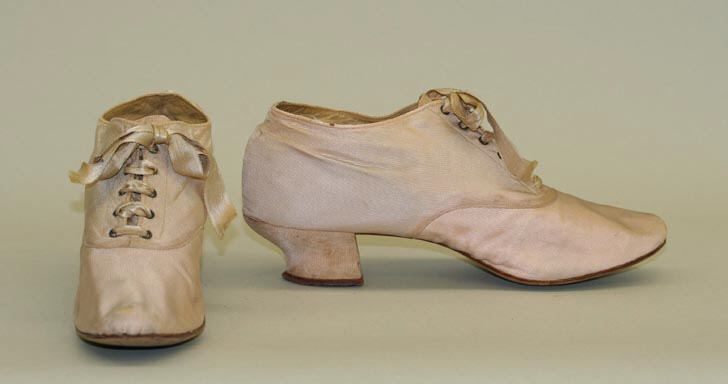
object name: oxford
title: Oxfords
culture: american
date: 1890-1899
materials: silk